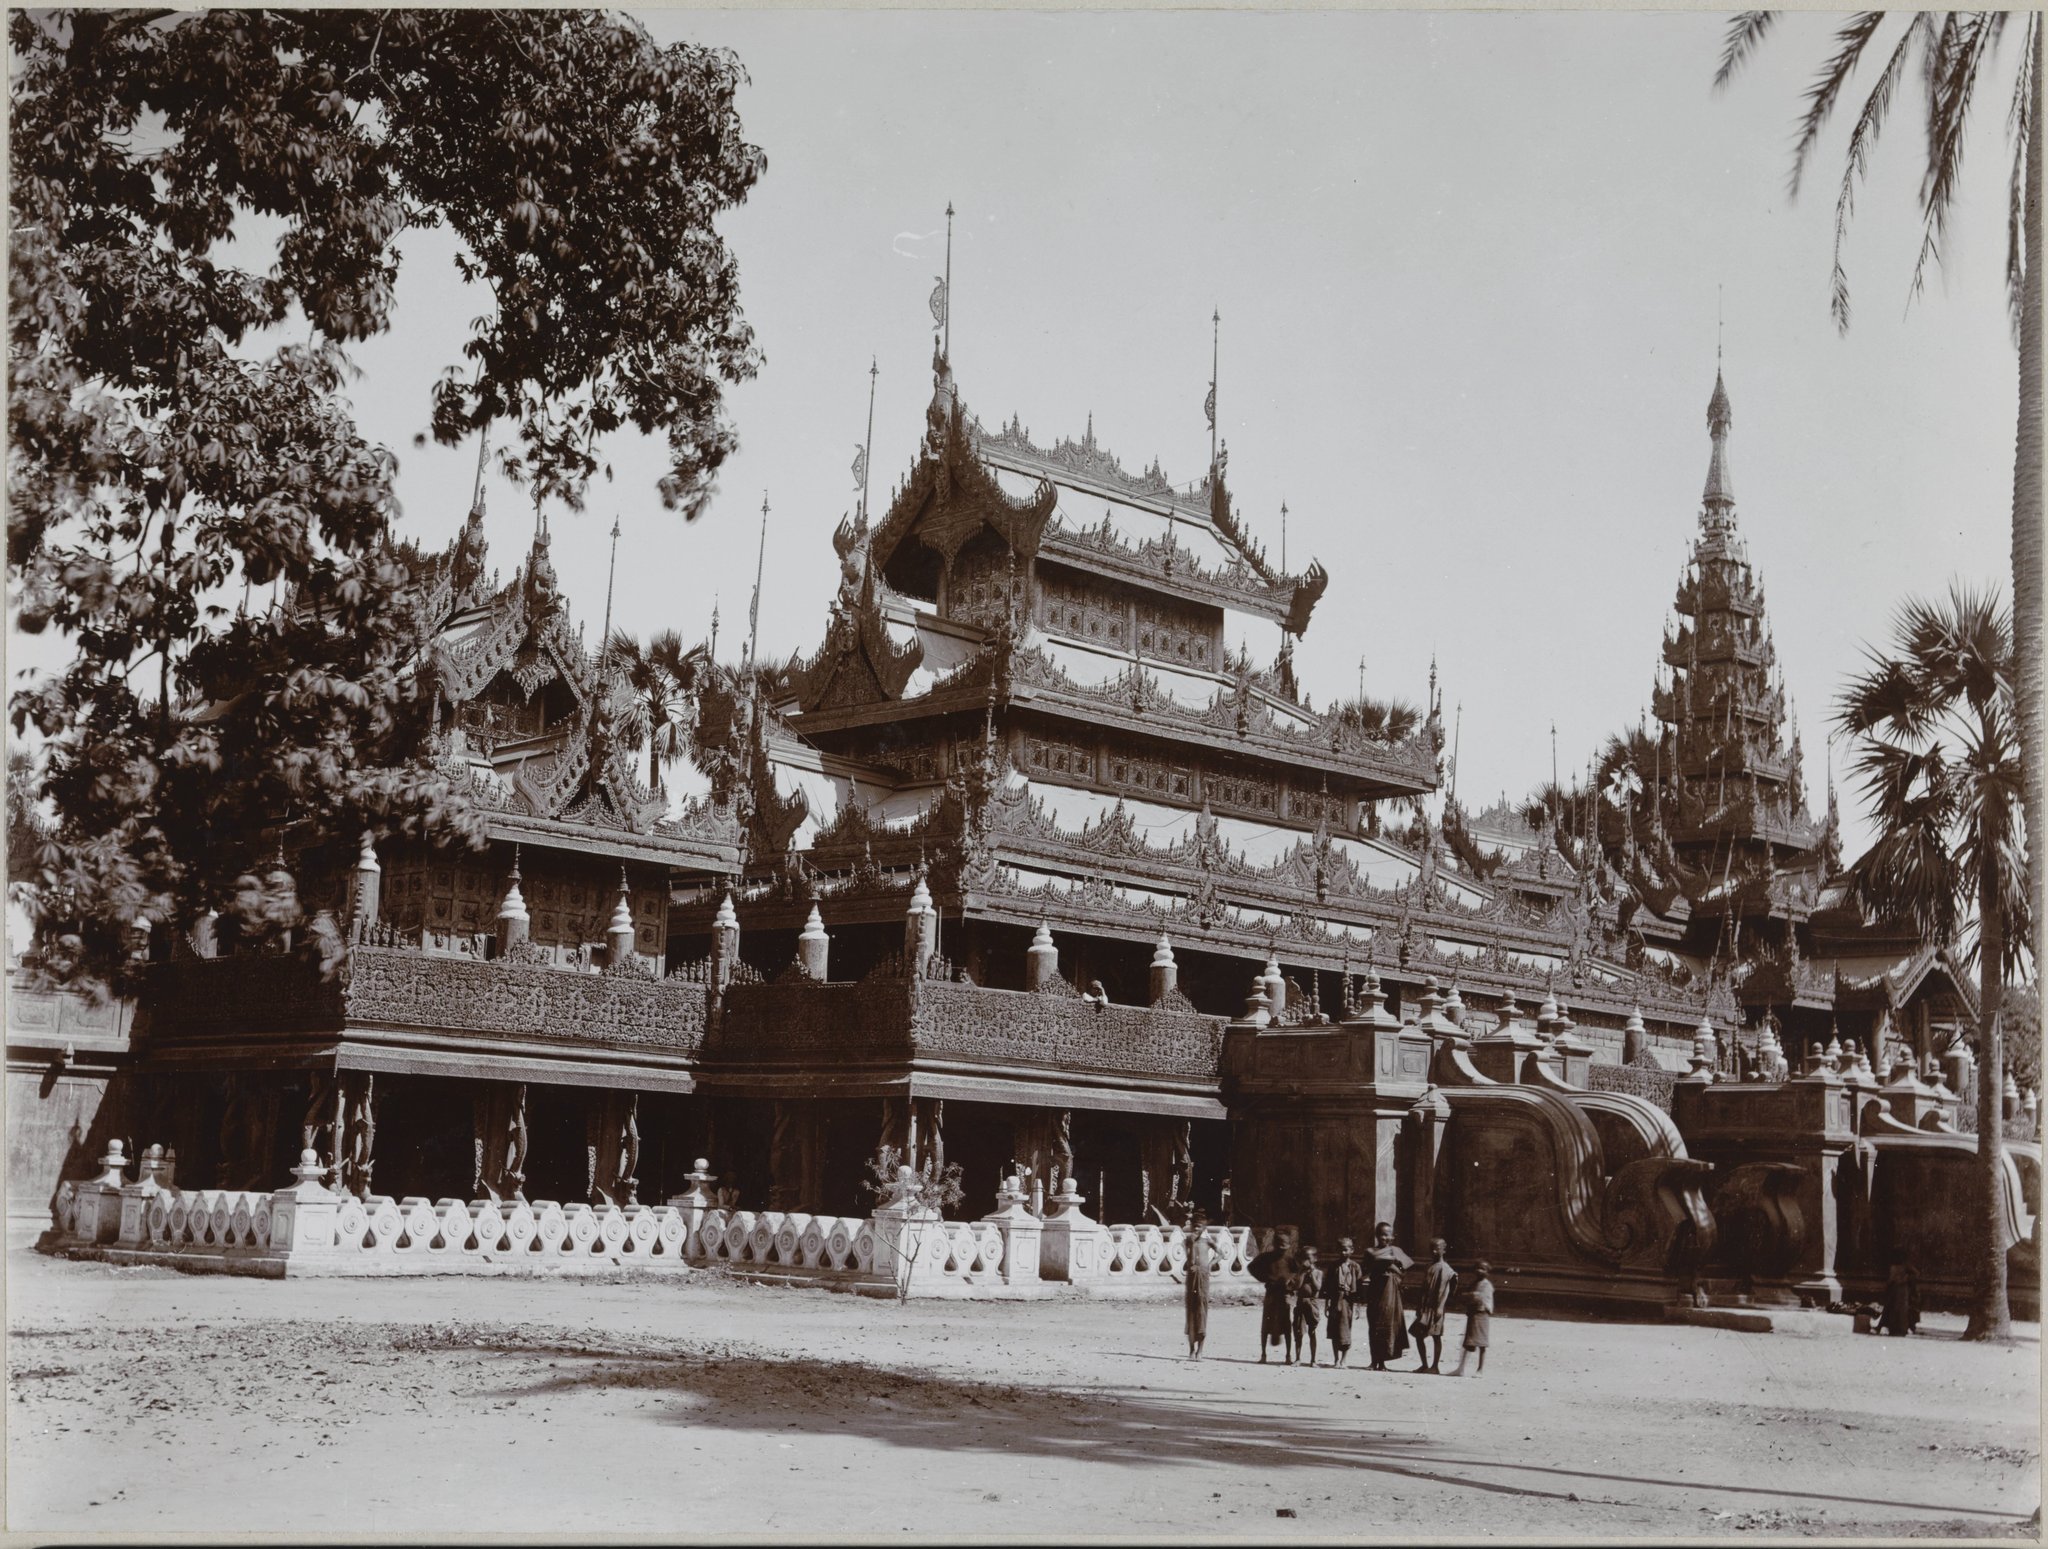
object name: photograph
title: Shwenandaw monastery, Mandalay, Myanmar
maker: Anonymous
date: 1895-1915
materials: cardboard, paper, photographic support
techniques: collodion silver print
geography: mandalay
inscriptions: inscription: ‘12. Gouden klooster der Koningin te Mandalay.’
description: Voor het Gouden Paleis Klooster staan zeven kinderen.